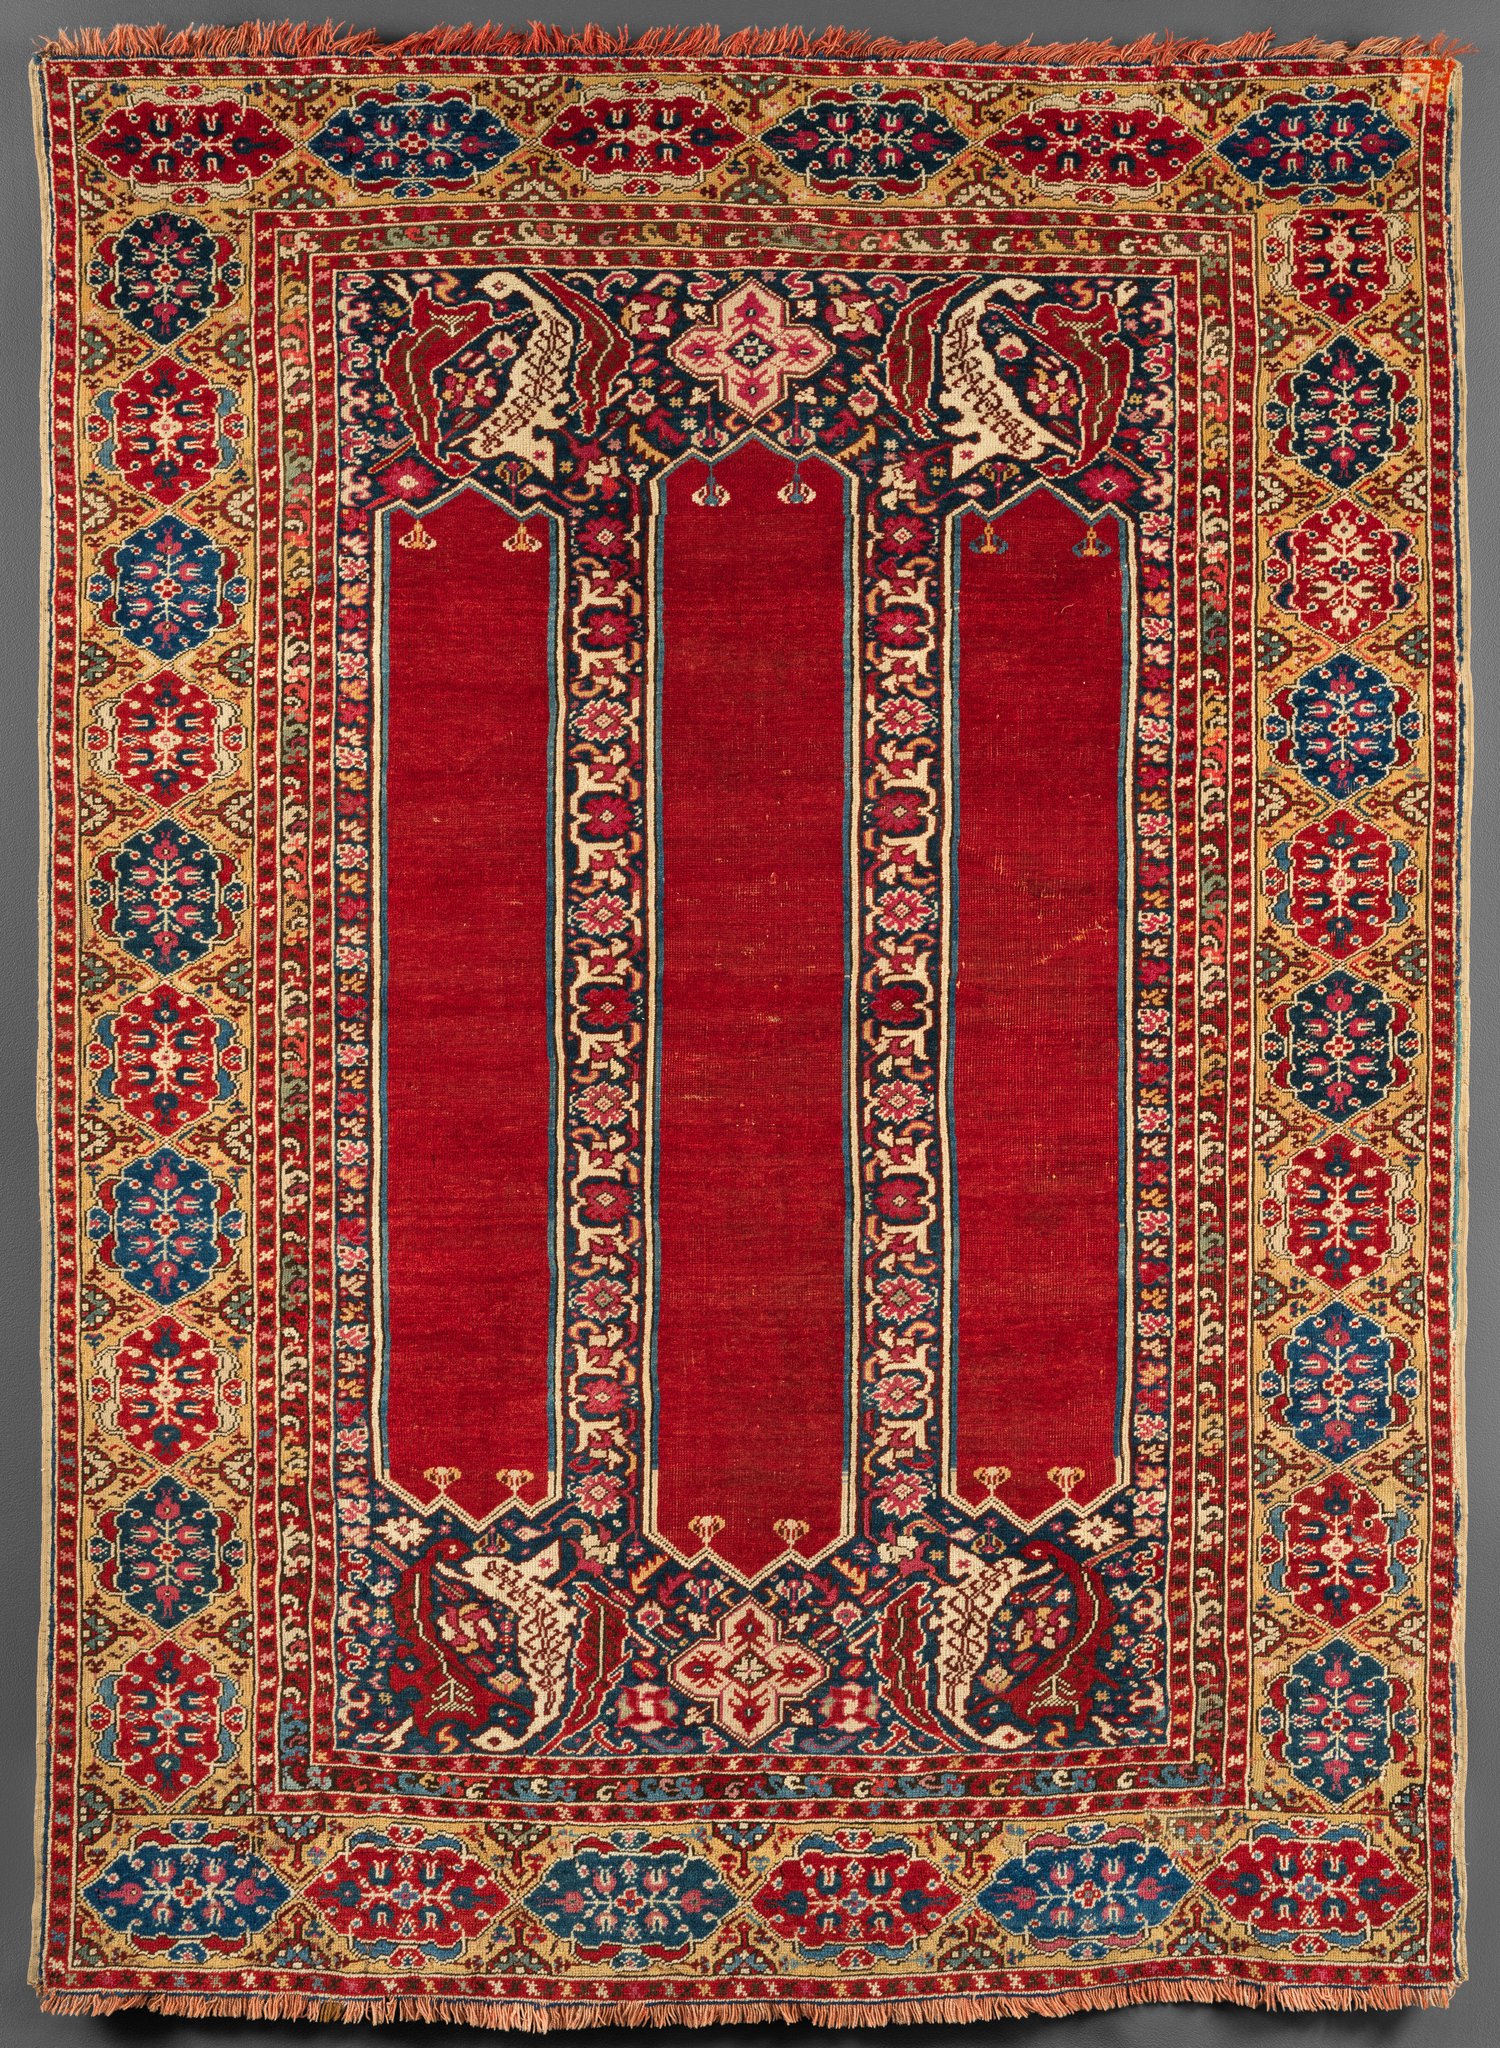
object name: carpet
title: Carpet with Double-Ended Triple Niche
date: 1701-1800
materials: wool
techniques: pile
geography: turkey